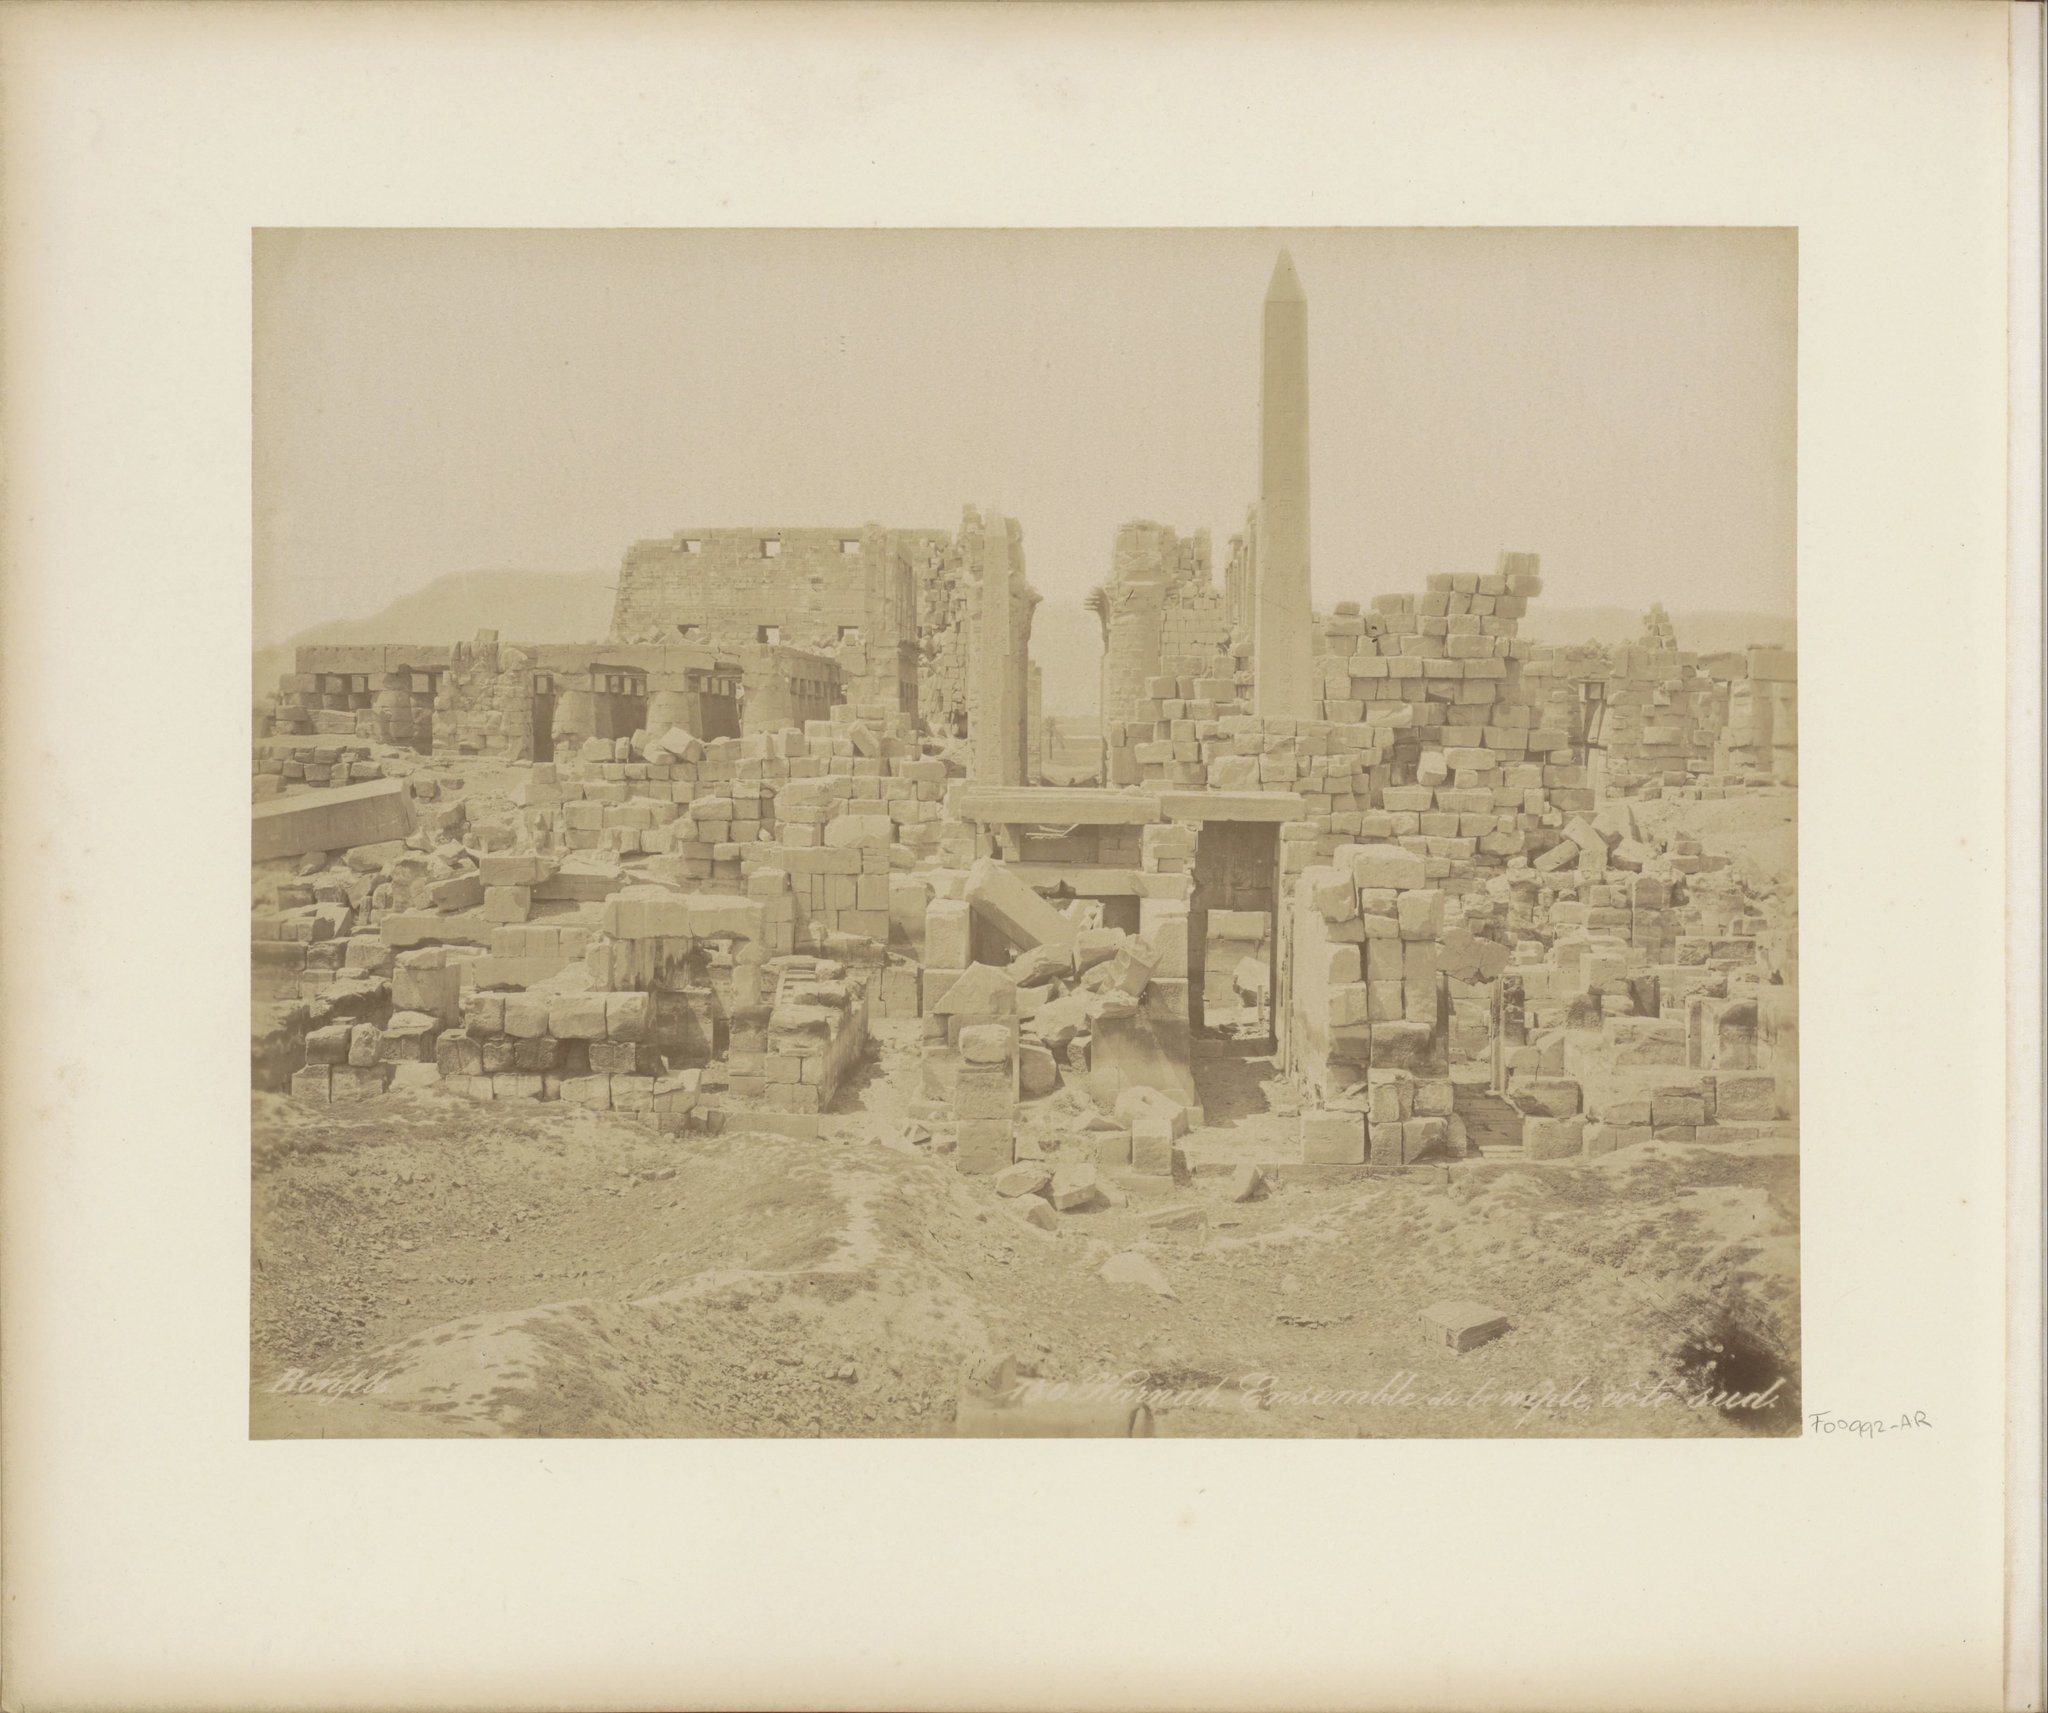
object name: photograph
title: Zuidzijde van het tempelcomplex van Karnak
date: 1870-1898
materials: cardboard, paper, photographic support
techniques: albumen print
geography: luxor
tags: temple, shrine ~ egyptian religion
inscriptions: negative number: ‘150’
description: Onderdeel van Reisalbum met 80 foto's van Egypte.